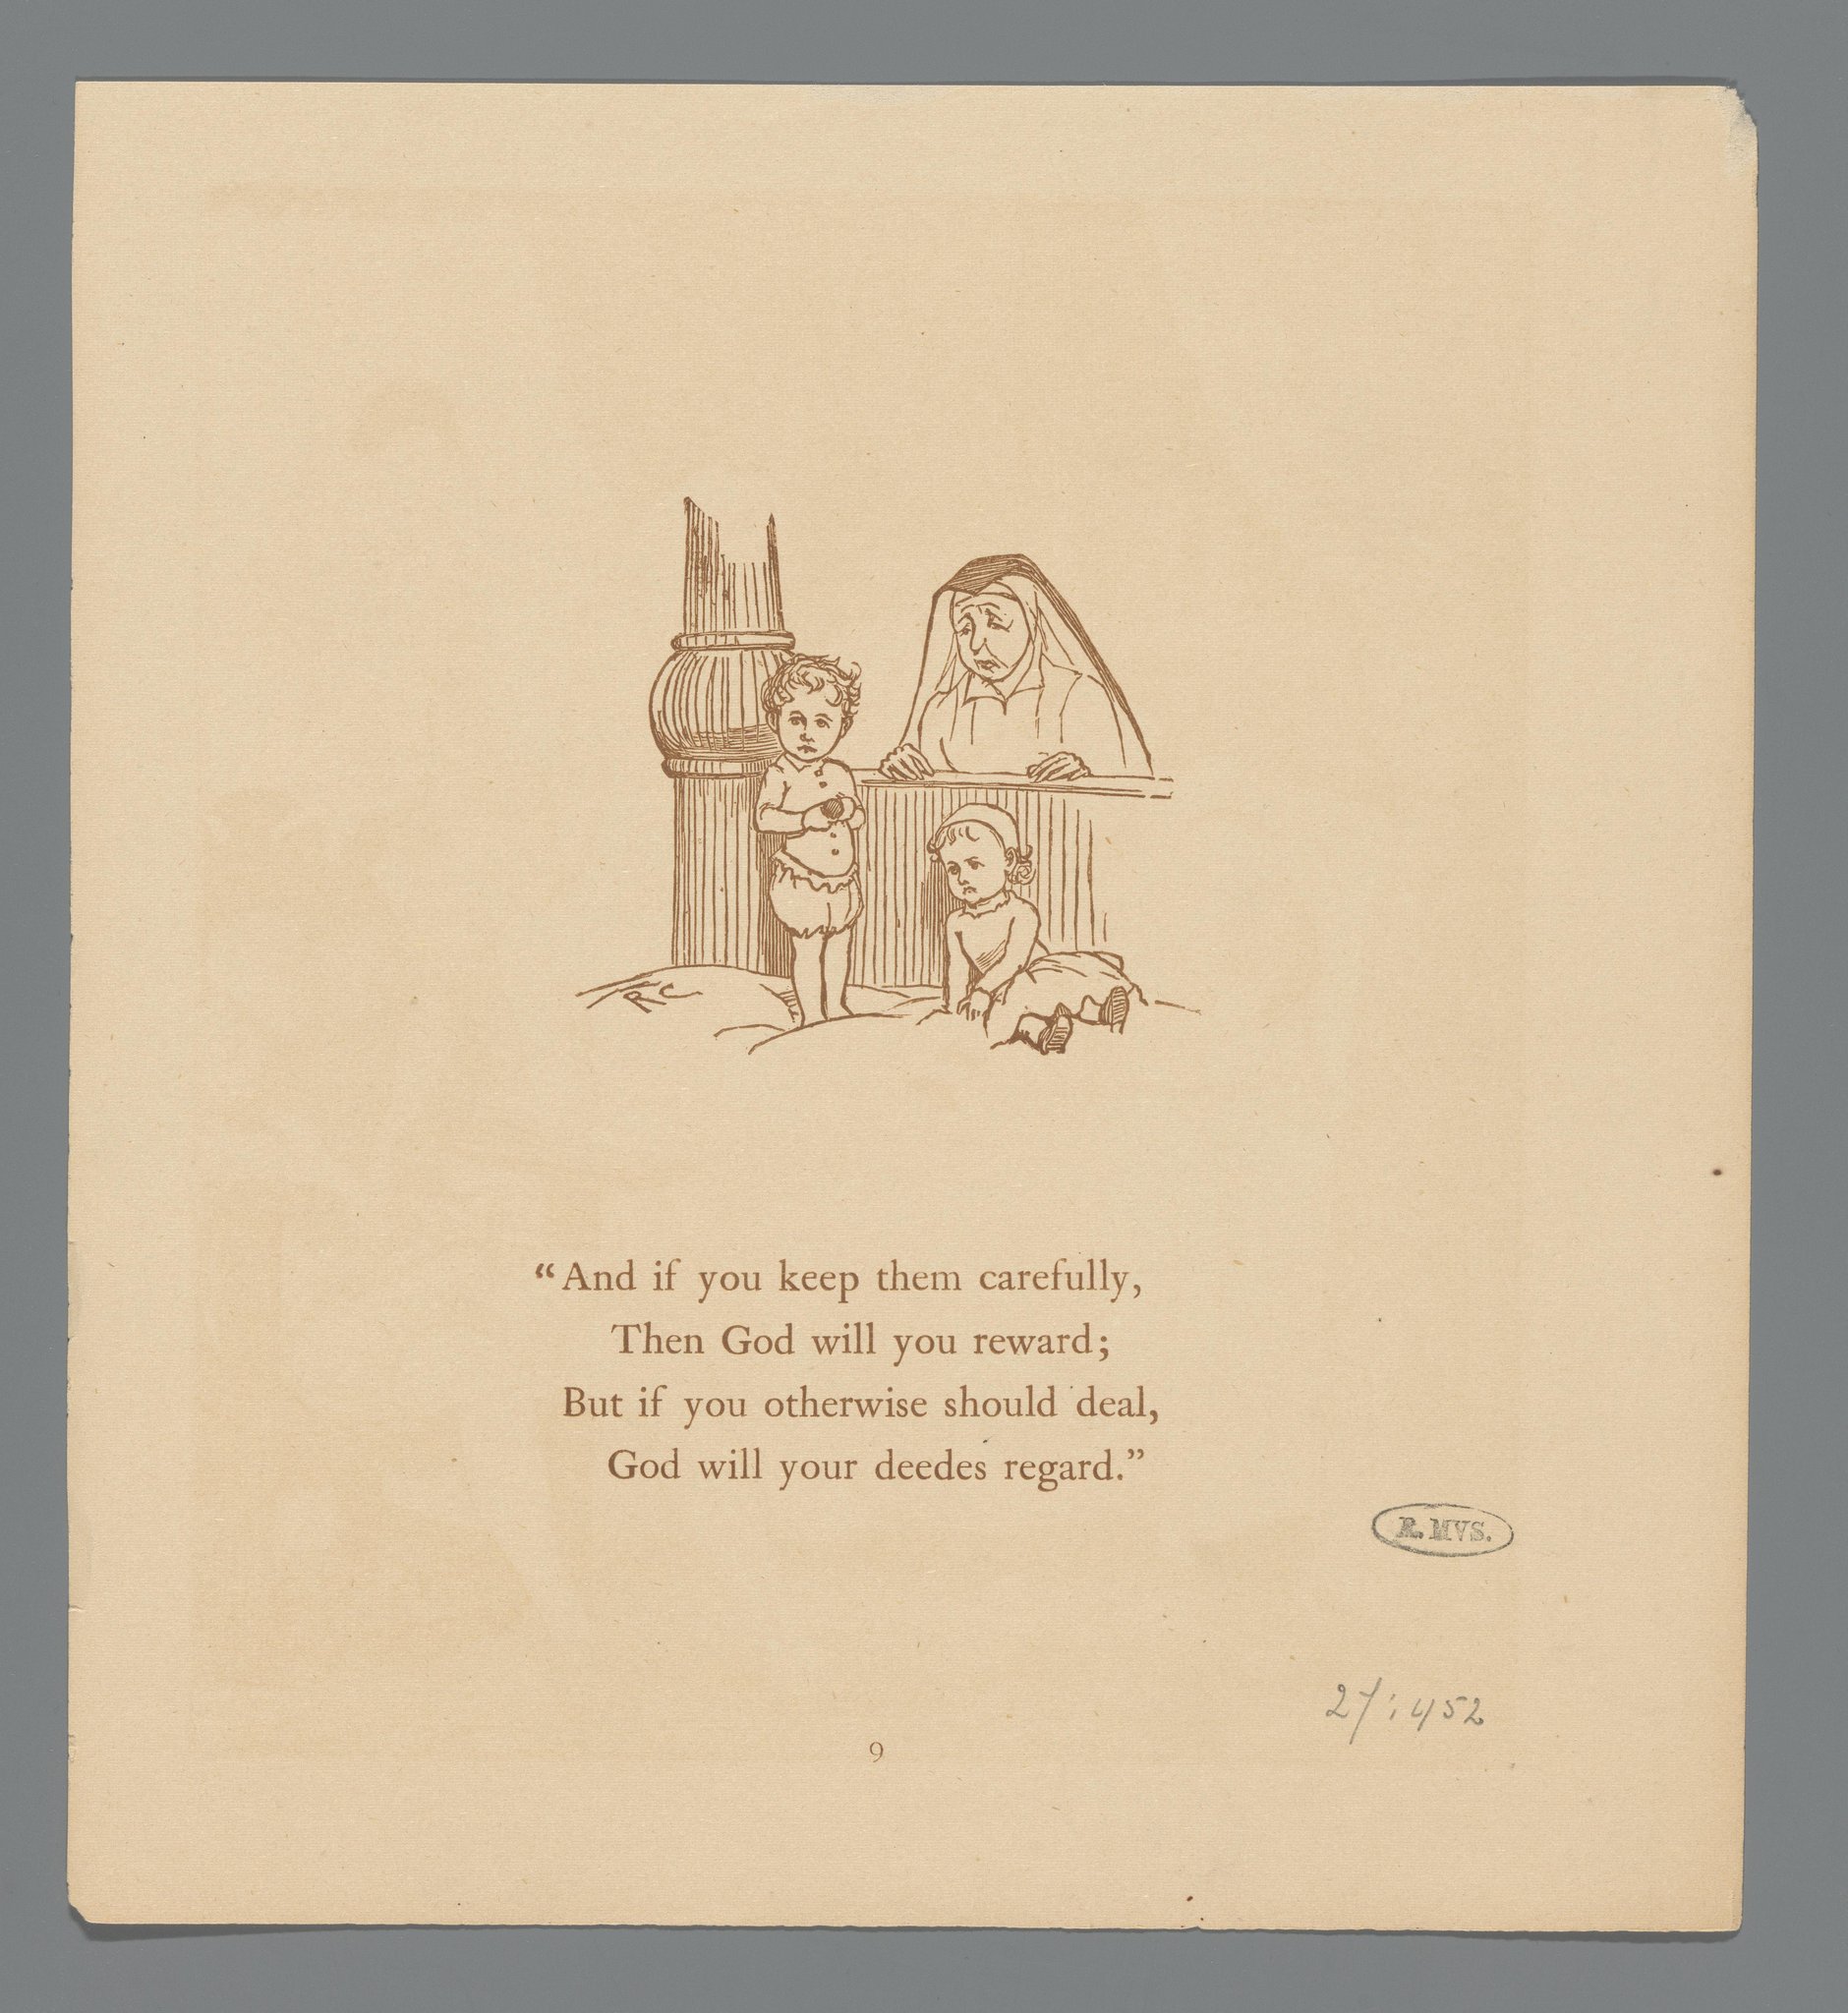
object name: print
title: Vrouw en twee kinderen aan de rand van een bed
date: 1879-1927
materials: paper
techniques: letterpress printing, engraving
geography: london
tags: adult woman, bed, child (+ two persons)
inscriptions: collector's mark: Lugt 2228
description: Prent uit: The babes in the wood. Londen: George Routledge & Sons, 1879. Of uit een later gepubliceerde (gebundelde) uitgave.